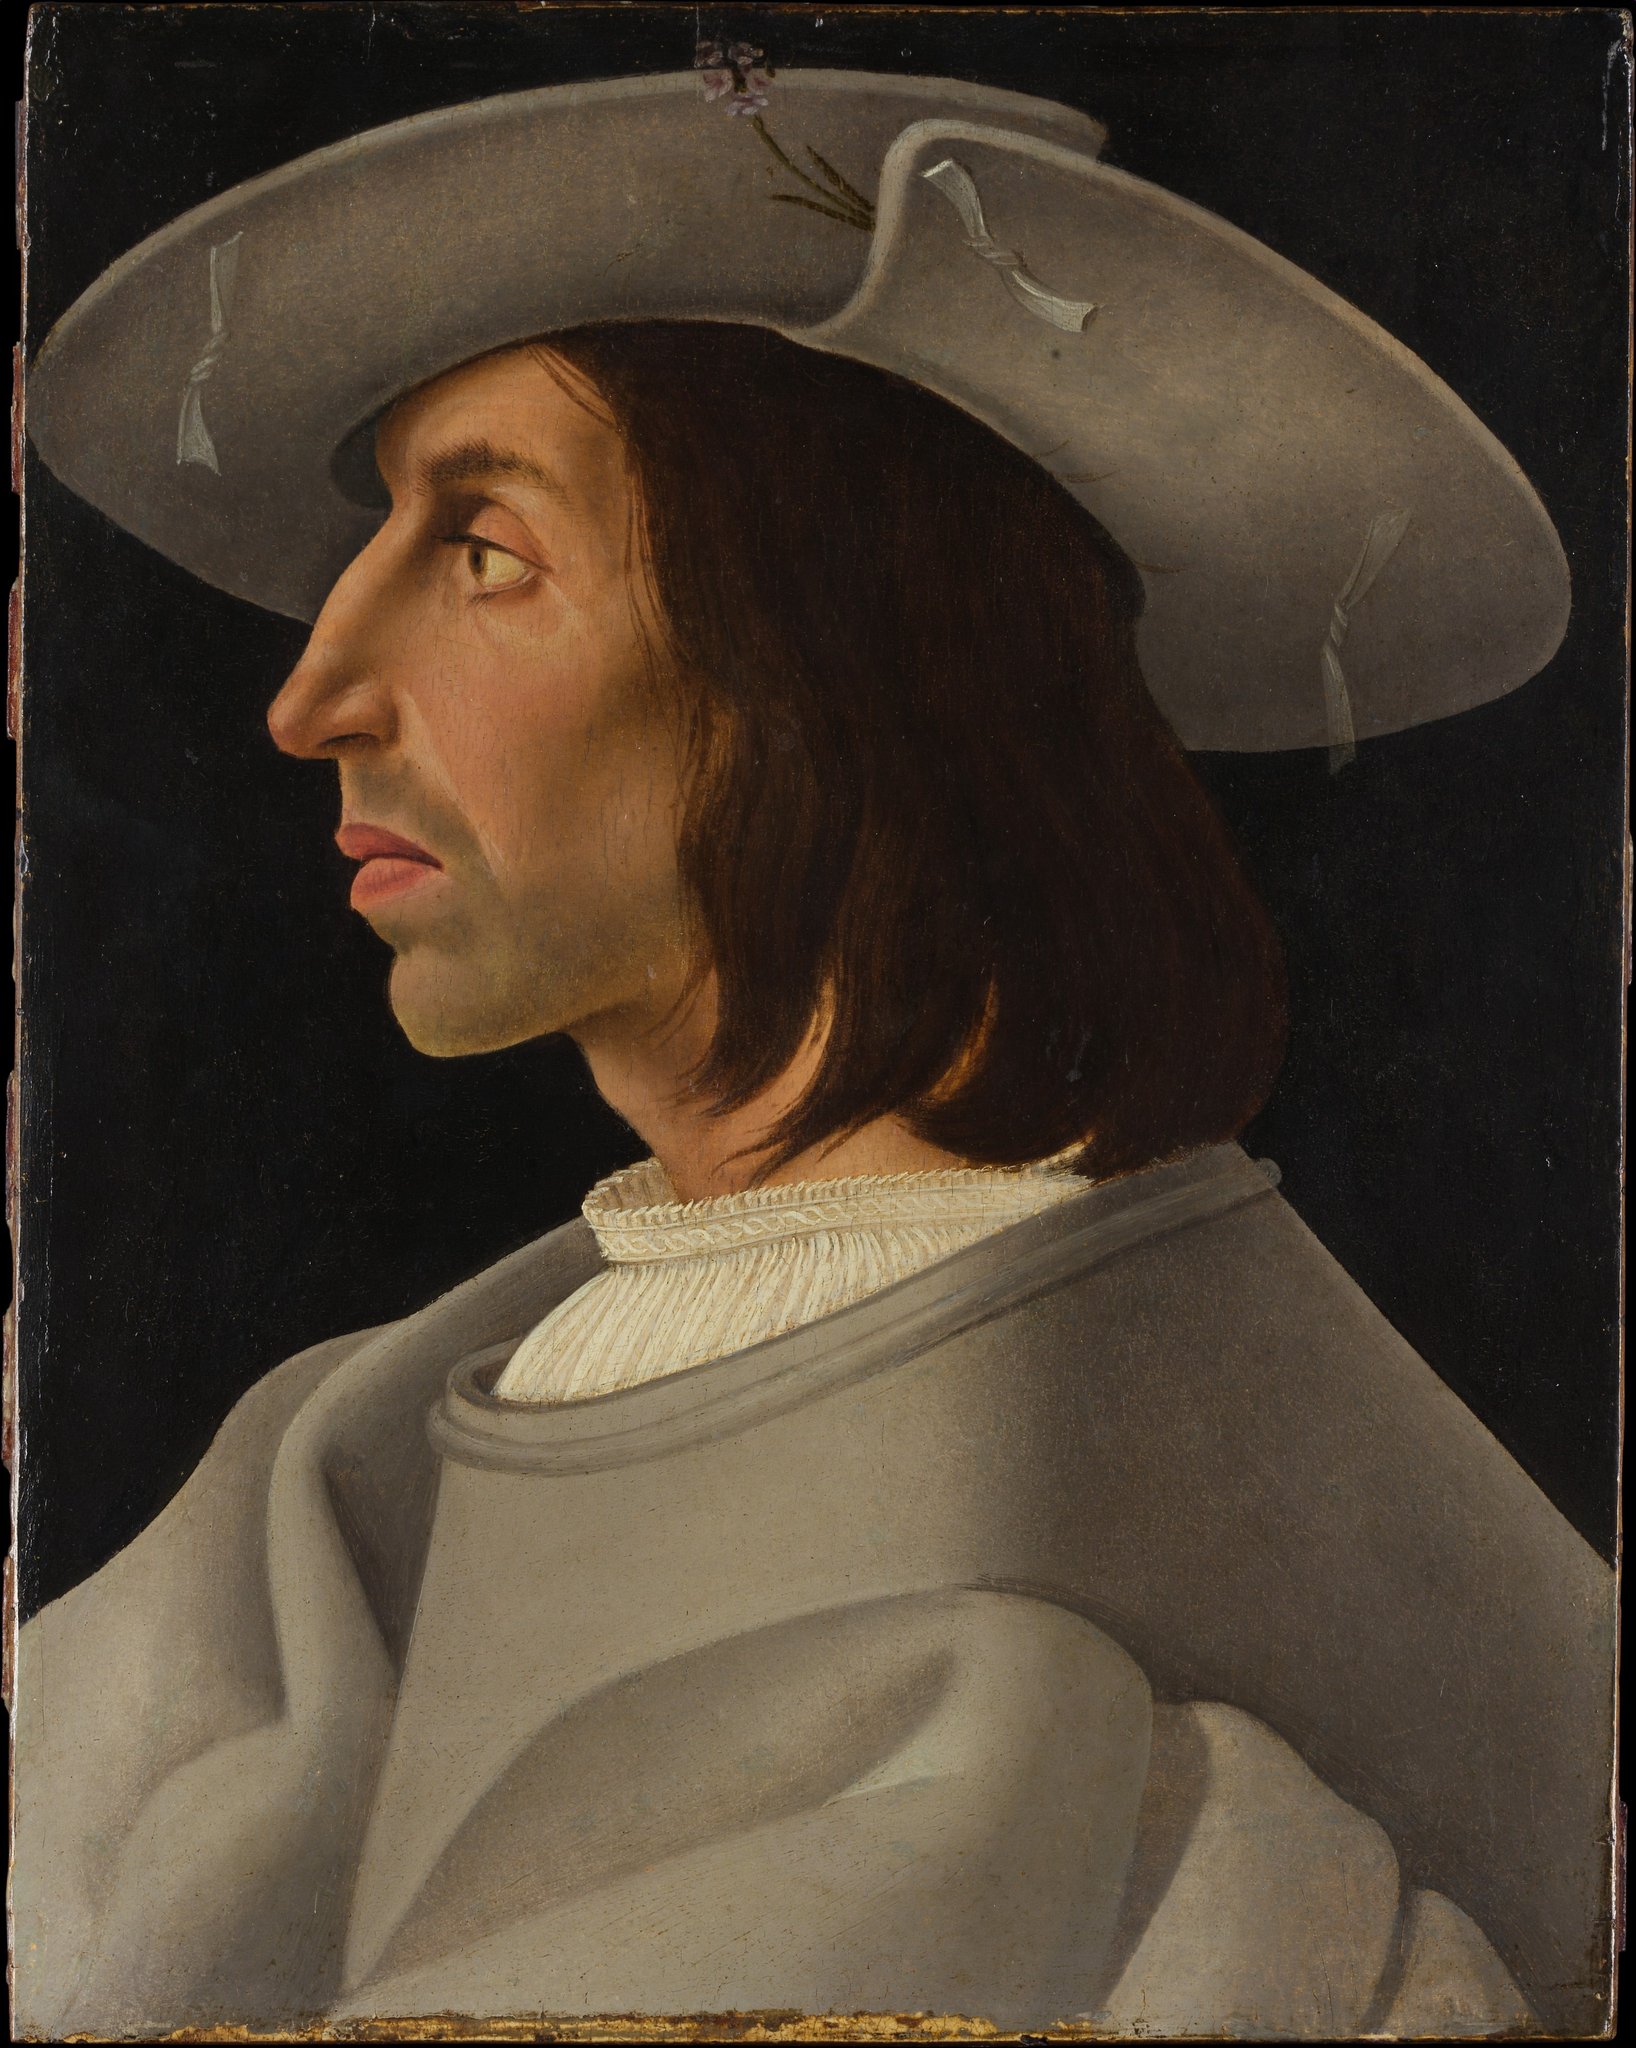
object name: painting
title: Portrait of a Man in Profile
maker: italian painter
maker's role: artist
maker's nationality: italian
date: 1520-1530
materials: oil, wood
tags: men,portraits,profiles